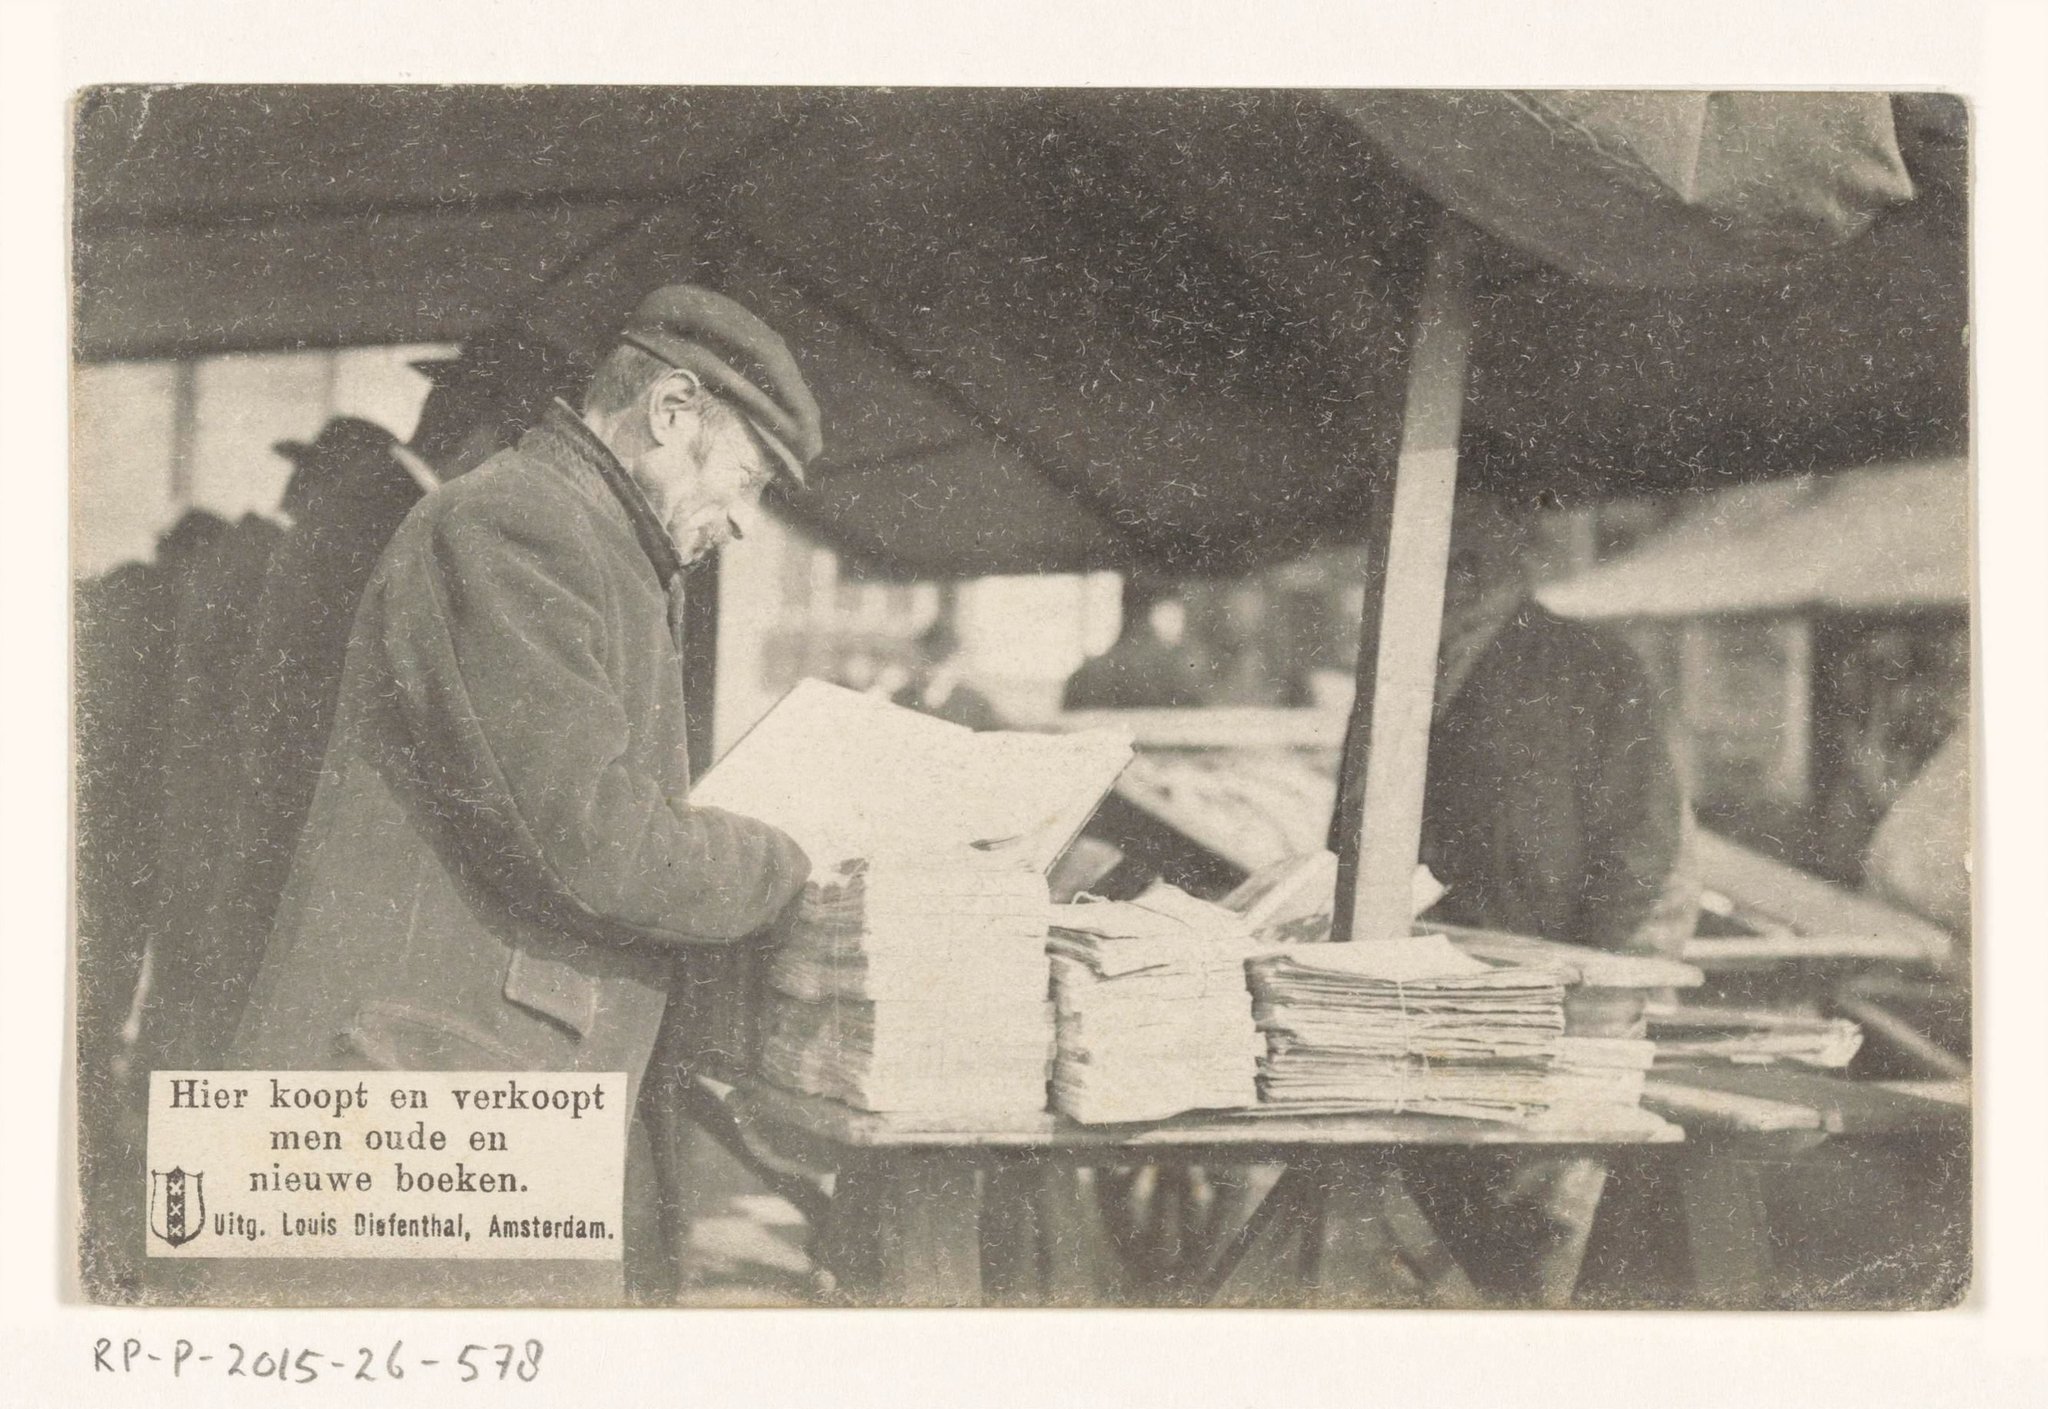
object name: ansichtkaart, prentbriefkaart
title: Boekenkraam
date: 1900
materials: paper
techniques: photograph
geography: amsterdam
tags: book-stall, kiosk, street-trader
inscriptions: collector's mark: Lugt 4779, collector's mark: Lugt 2228